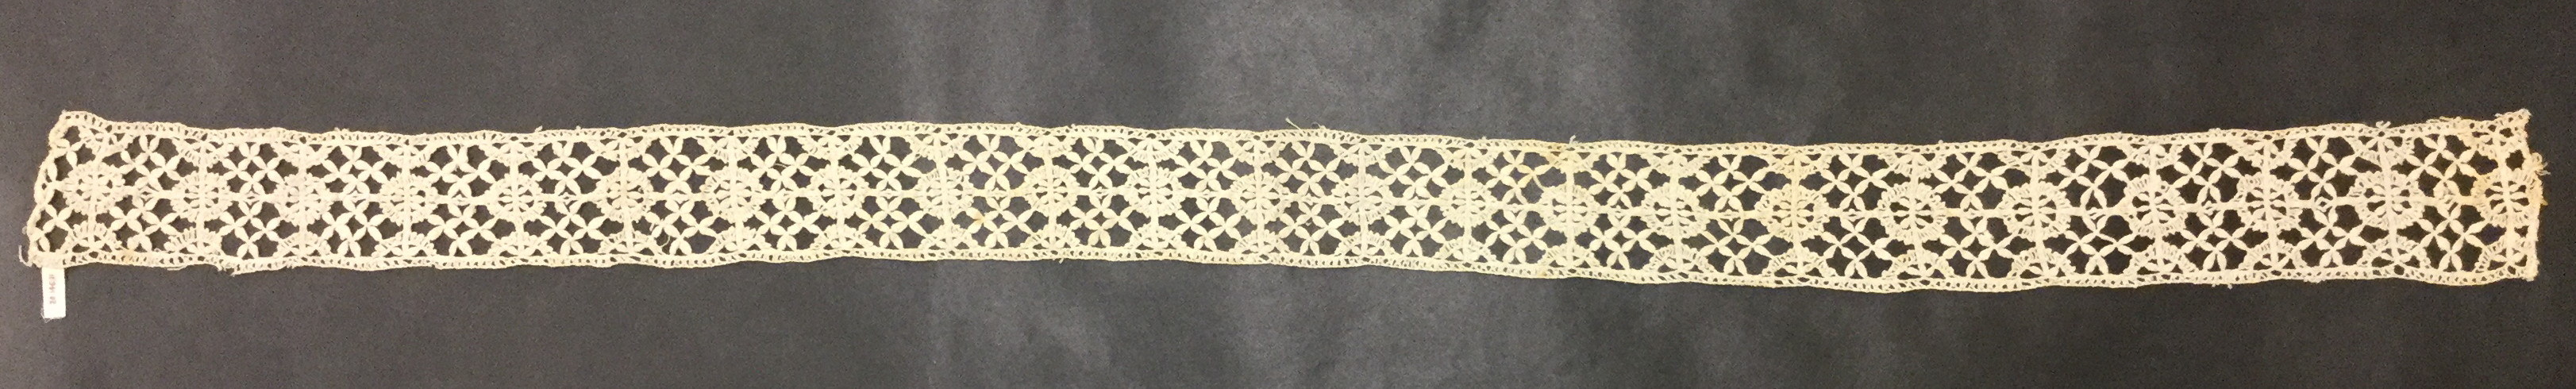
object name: fragment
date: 1601-1700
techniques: lace